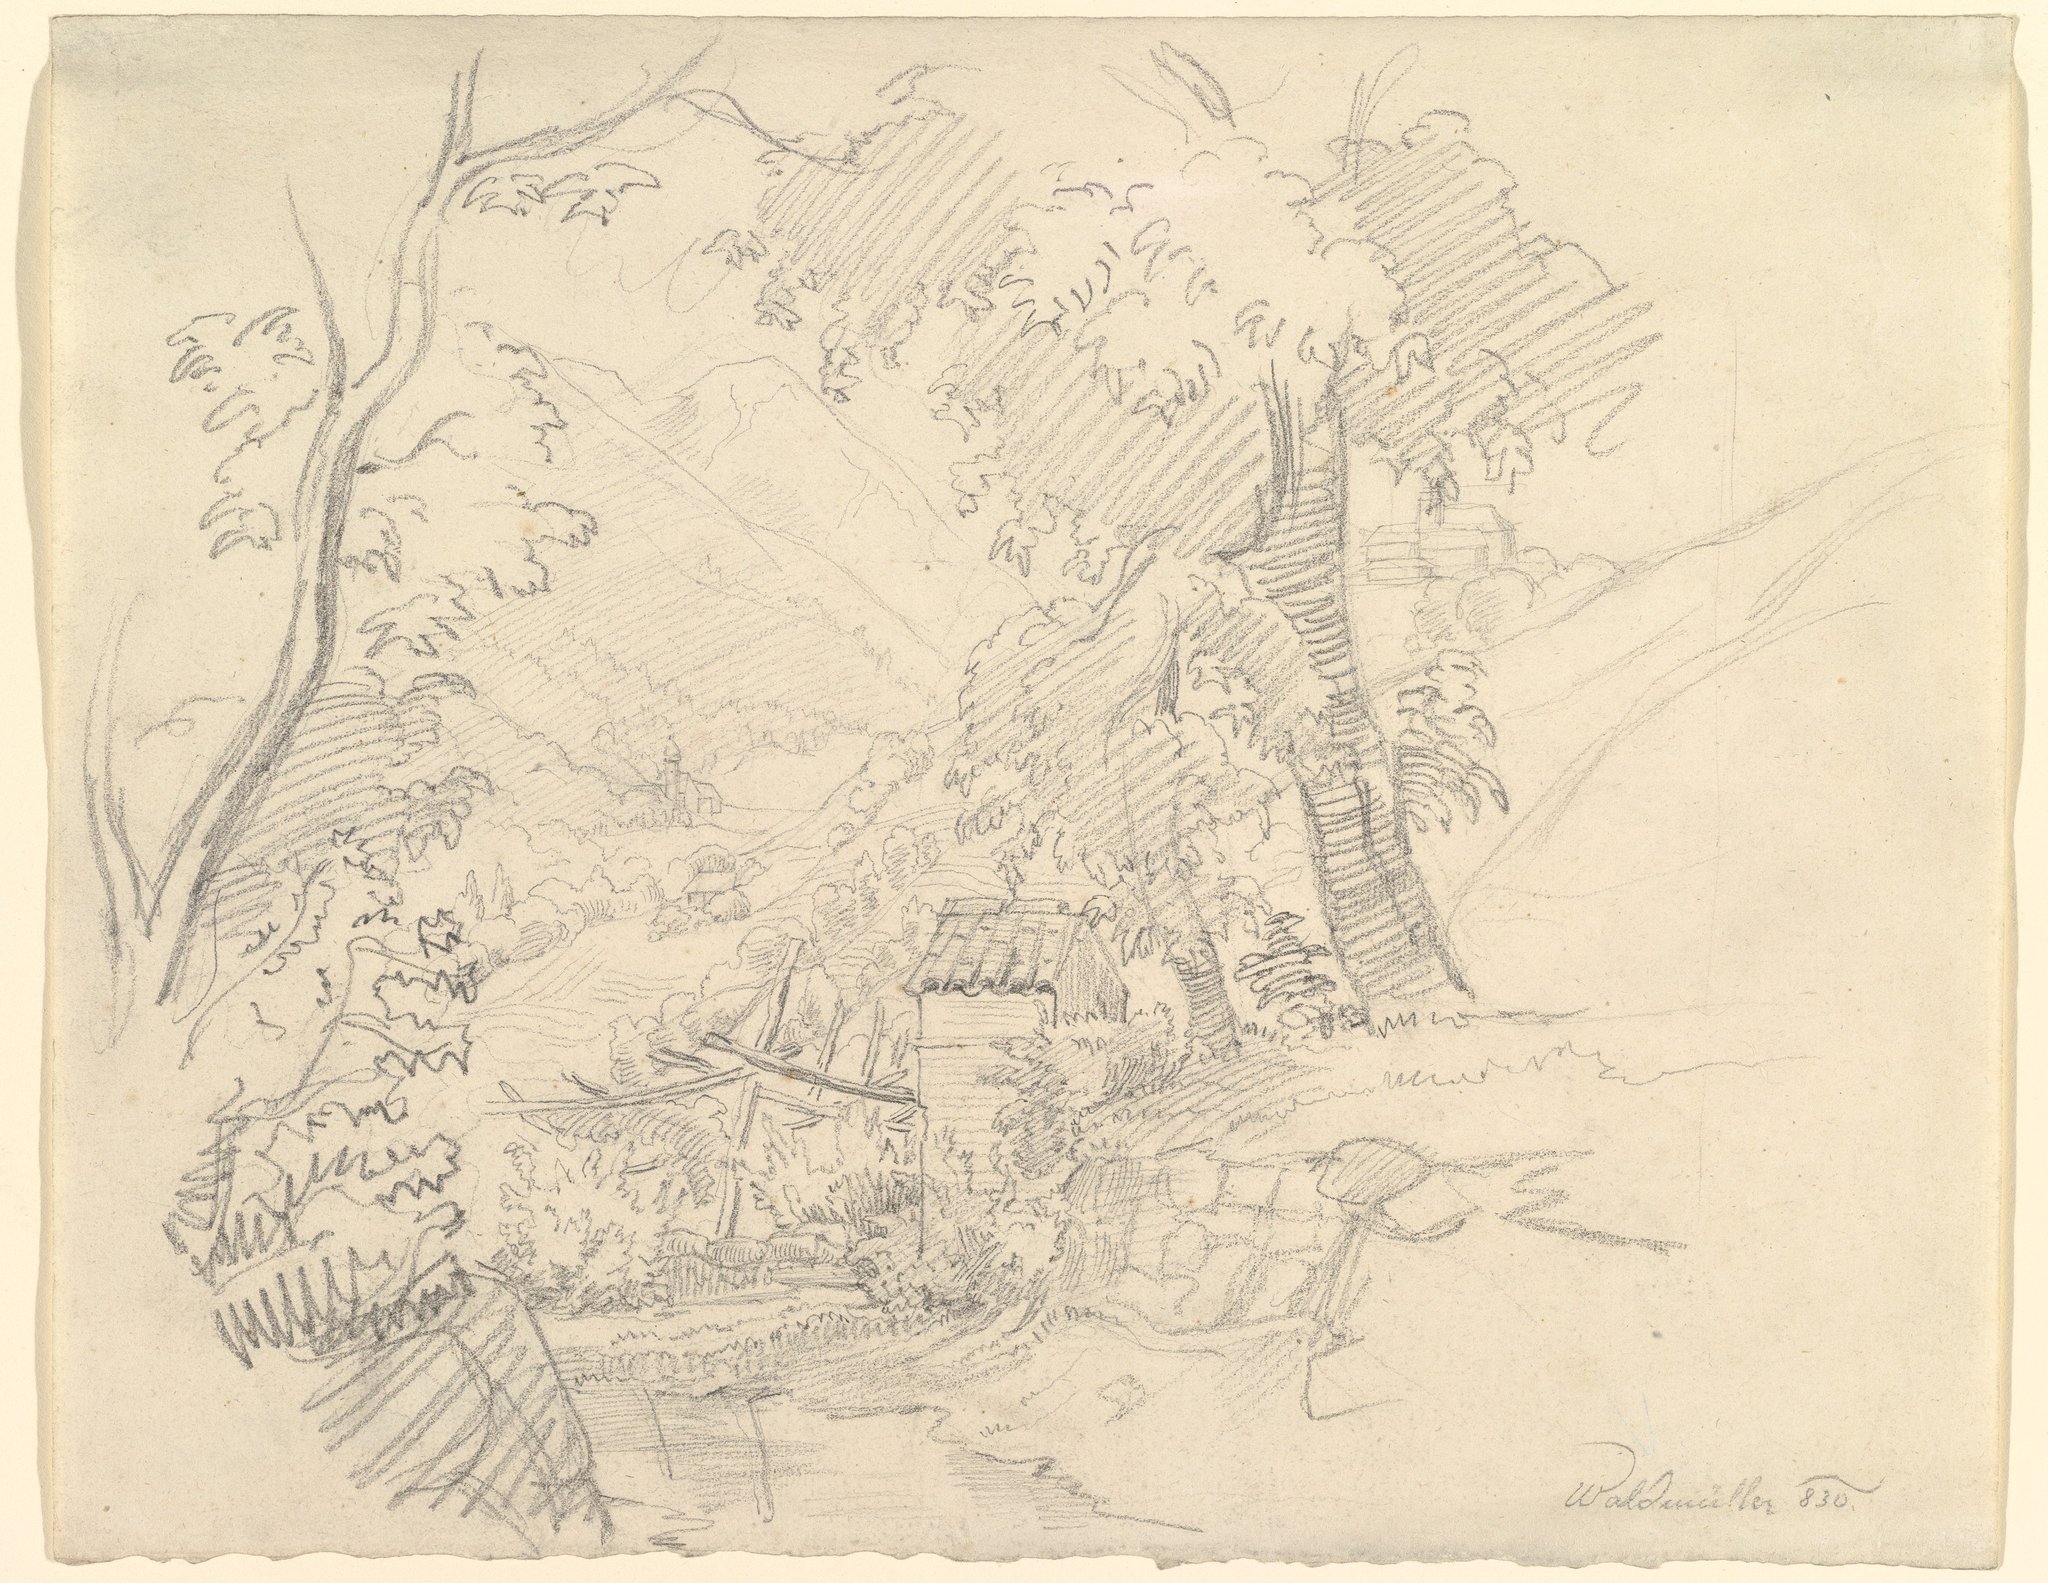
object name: drawing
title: Landscape with a View in a Valley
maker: ferdinand georg waldmüller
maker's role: artist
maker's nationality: austrian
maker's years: 1793-1865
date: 1830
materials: graphite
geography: germany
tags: landscapes,trees